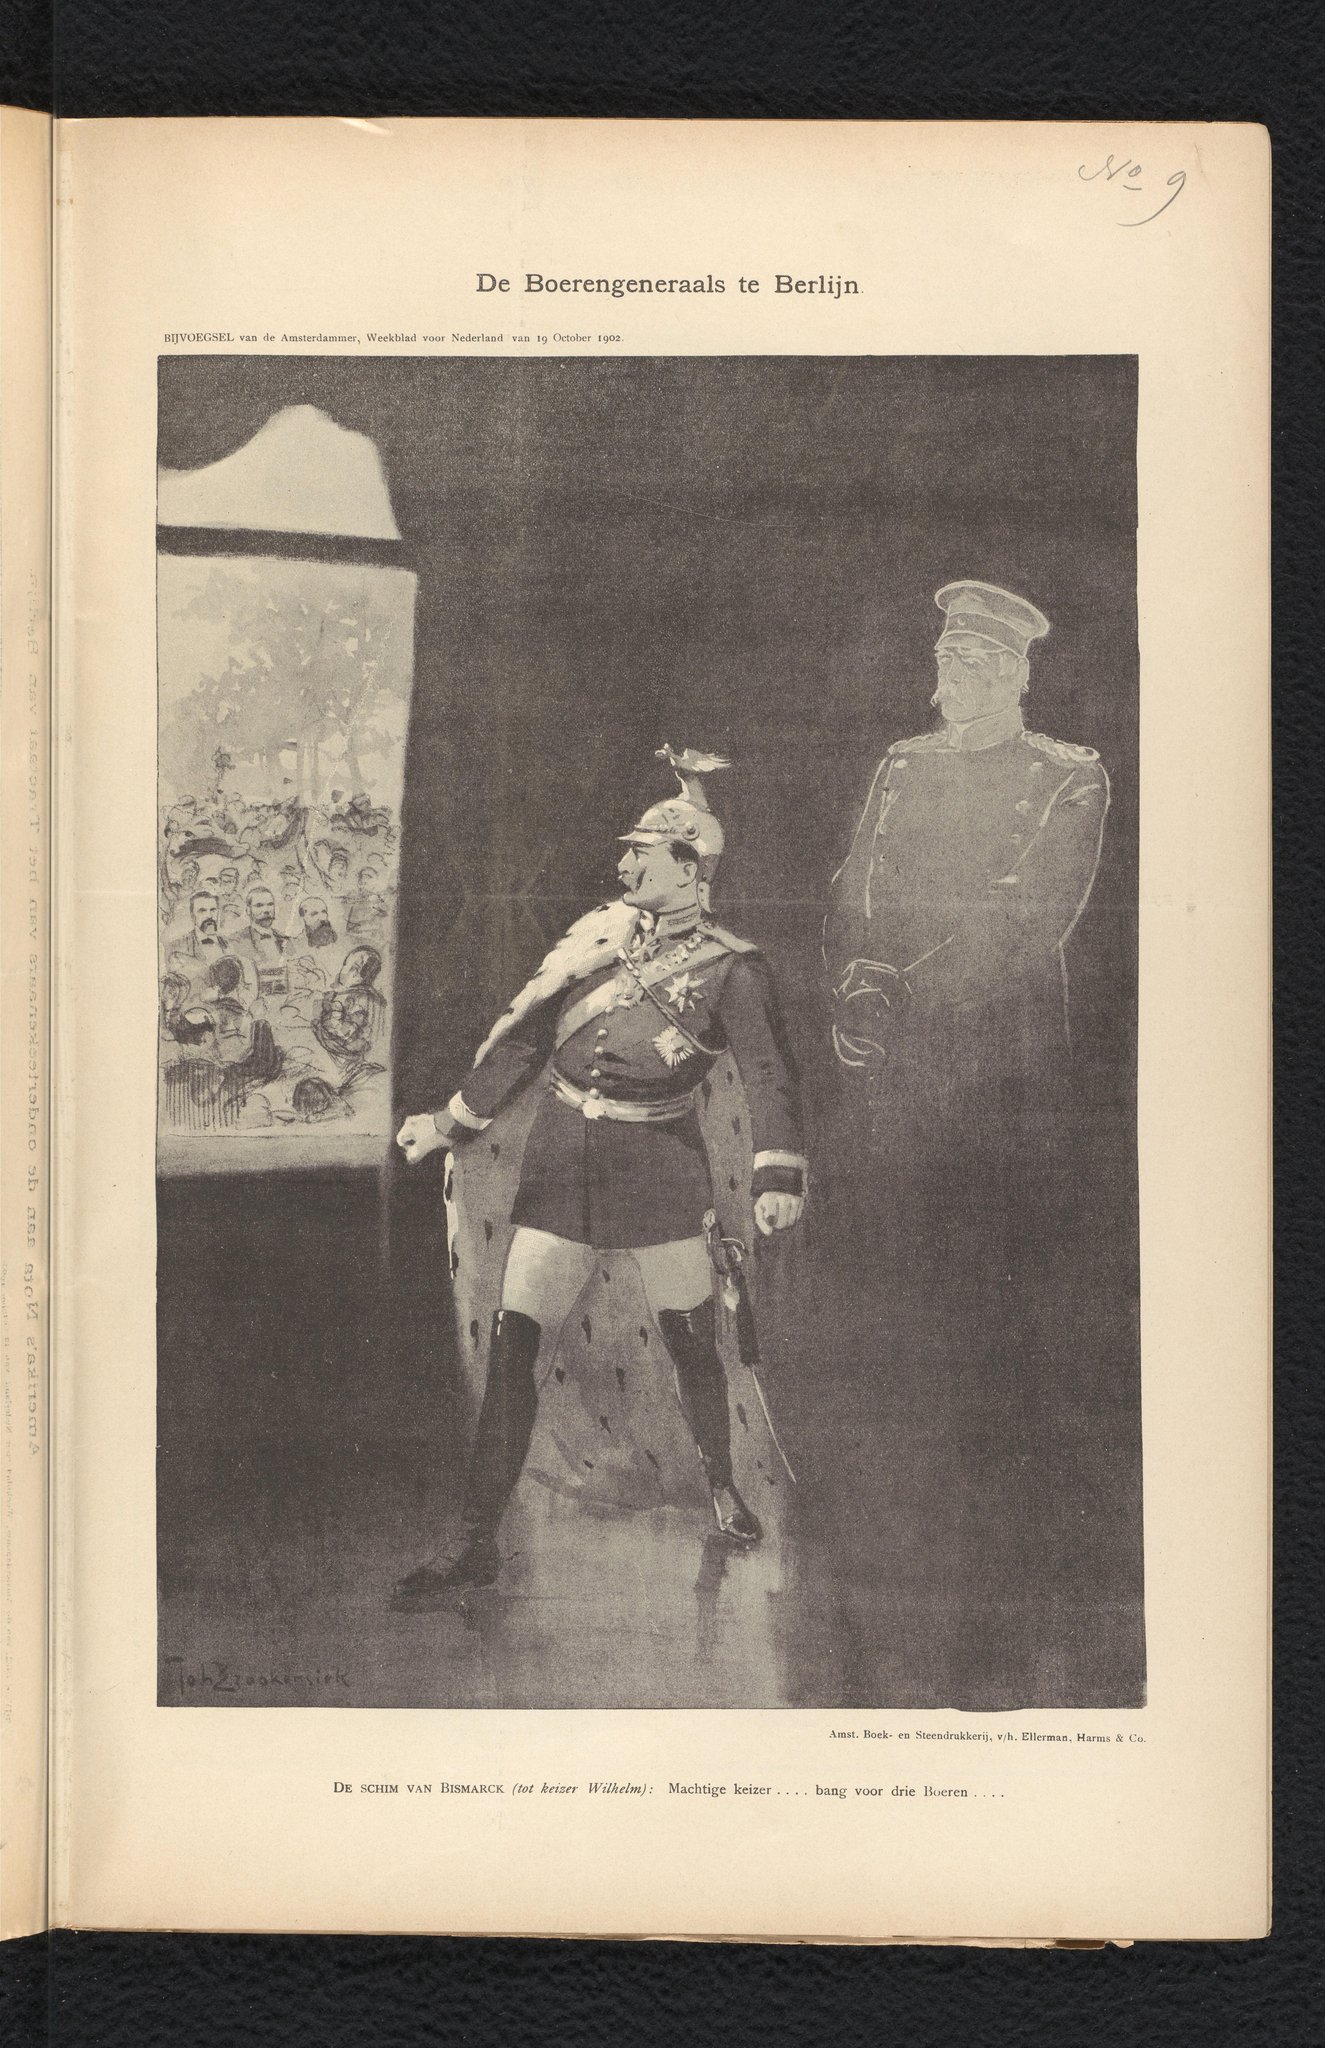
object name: cartoon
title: De Boerengeneraals te Berlijn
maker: johan braakensiek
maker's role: draughtsman, print maker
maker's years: 1858-1940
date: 1902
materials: paper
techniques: autotype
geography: netherlands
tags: wilhelm ii (keizer van duitsland), politician, spirit, ghost, political caricatures and satires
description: De Duitse keizer Wilhelm II schrikt terug als hij door het raam de drie bezoekende Boerengeneraals ziet. Achter hem de spottende schim van Bismarck. Christiaan de Wet, Louis Botha en Koos de la Rey reizen door Europa om fondsen te werven voor de weduwen en weeskinderen uit de Boerenoorlog.